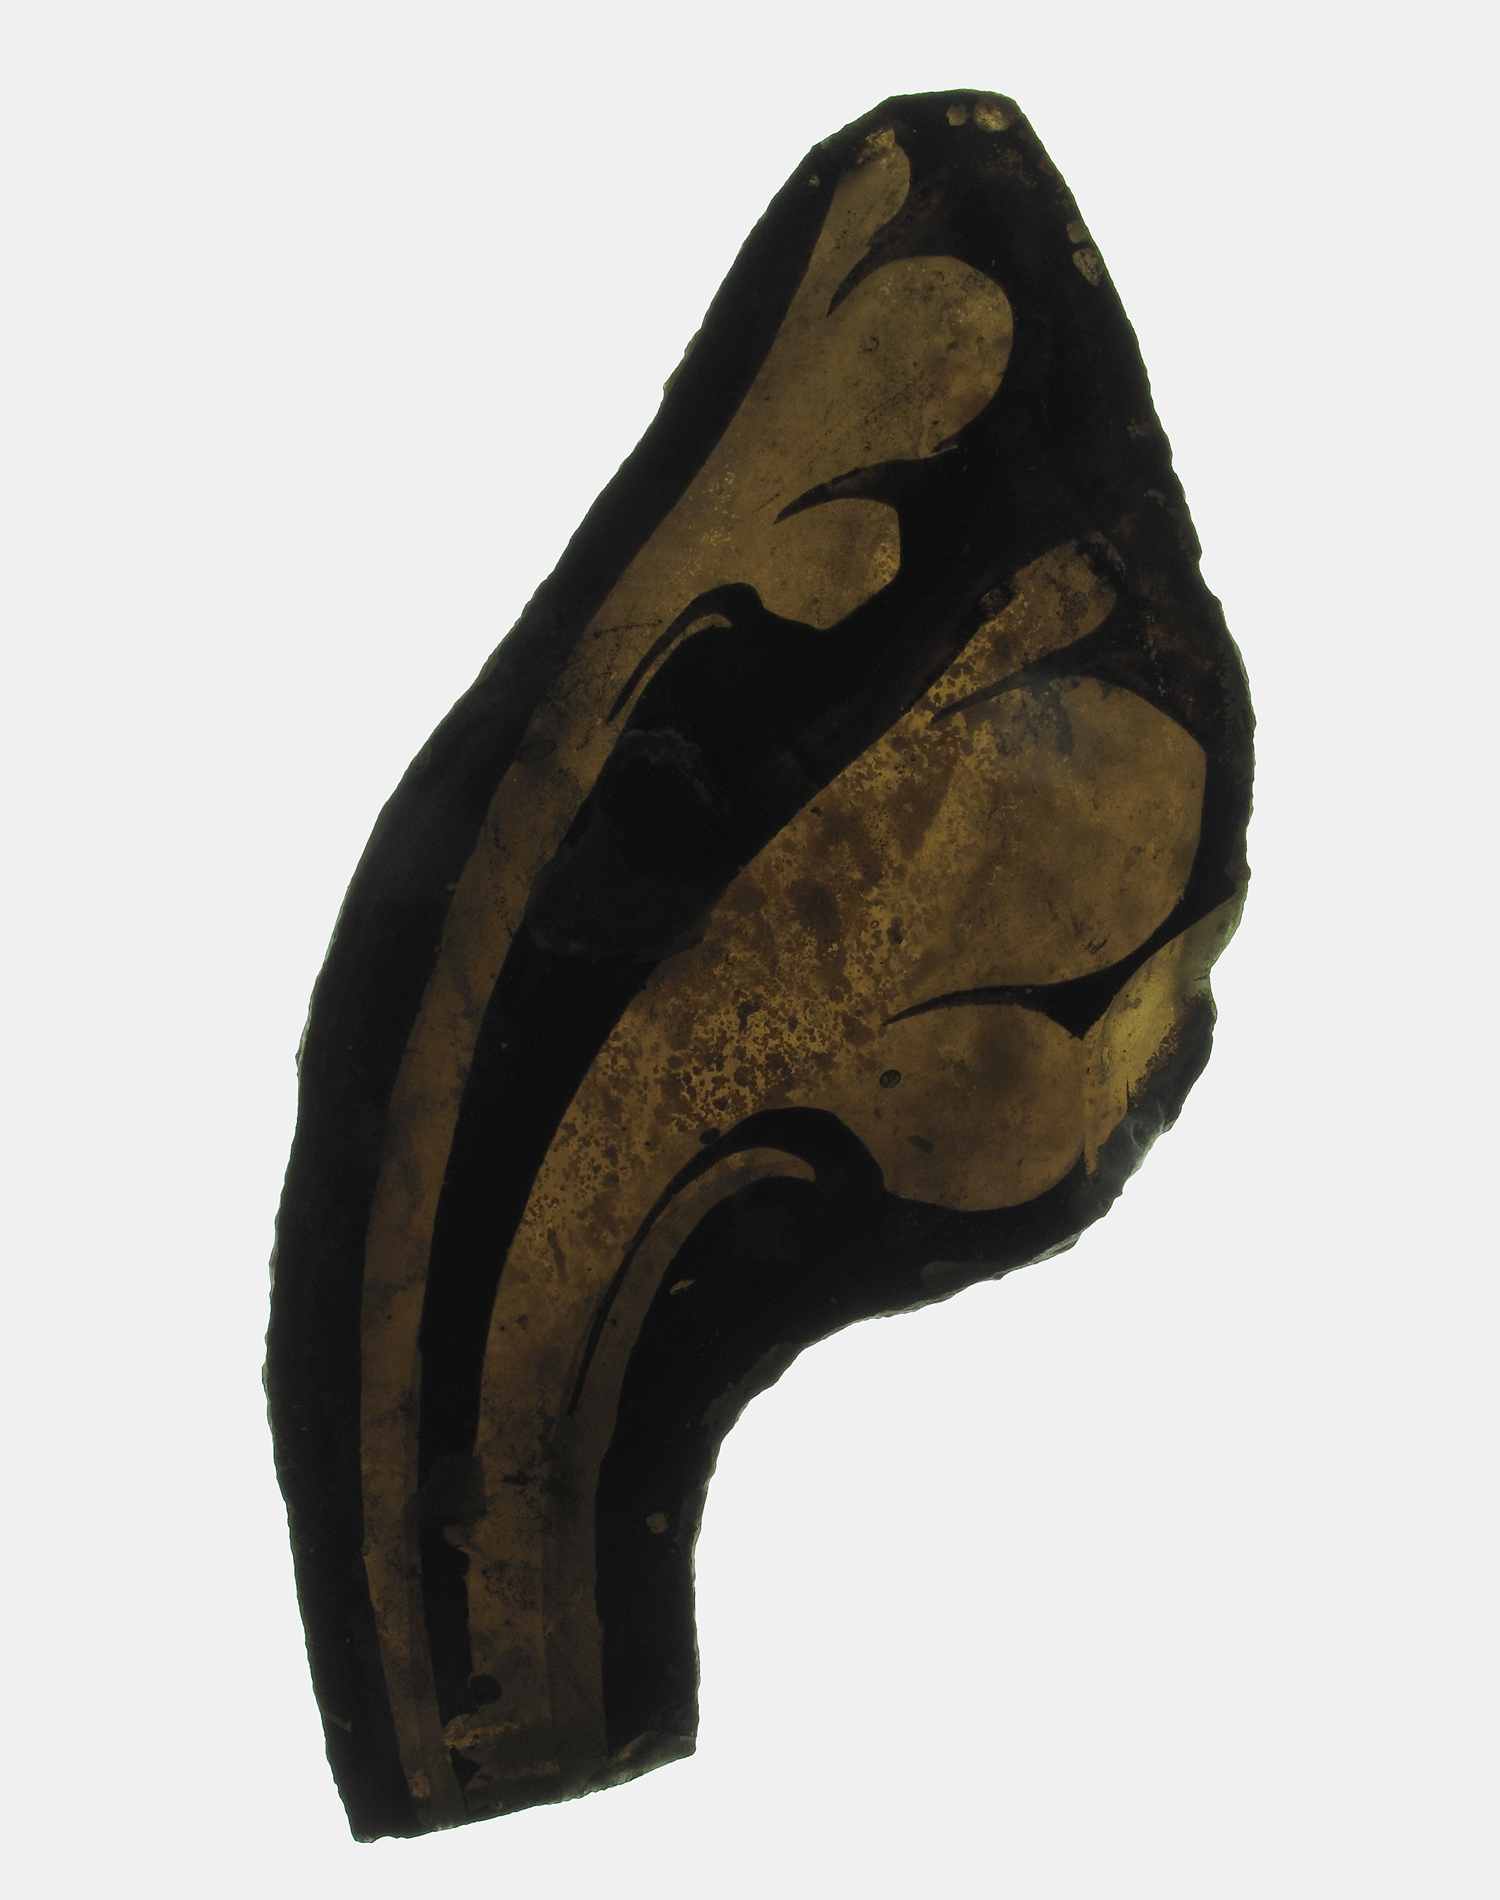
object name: fragment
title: Glass Fragment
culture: european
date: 1201-1300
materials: glass, metal